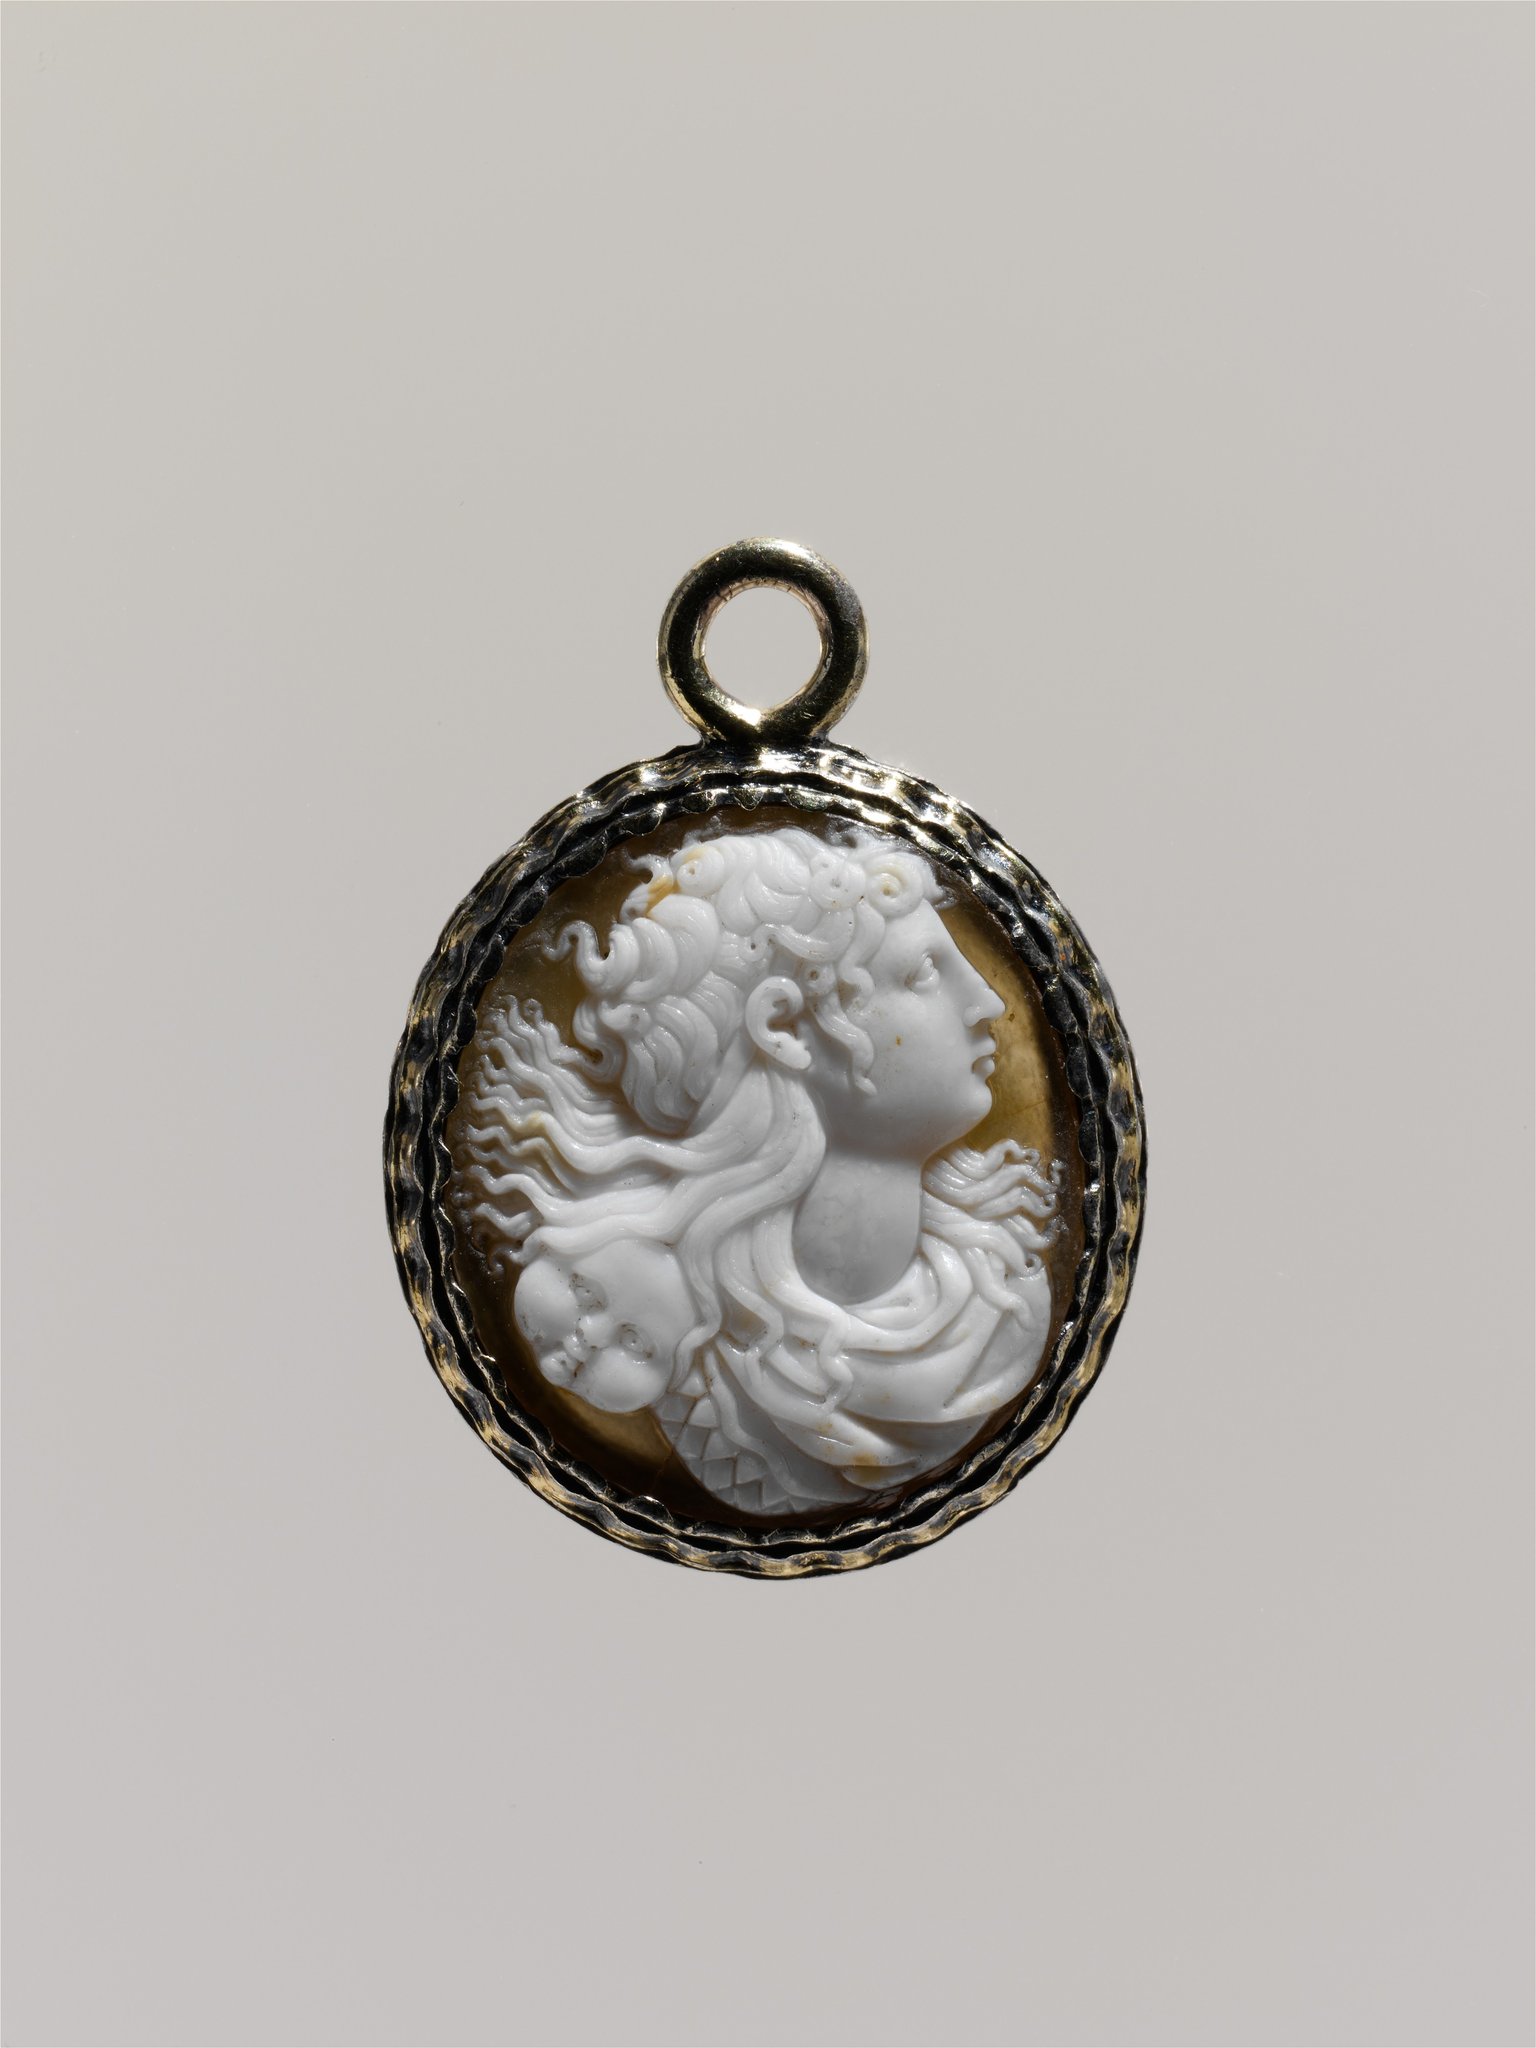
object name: cameo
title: Head of a Medusa (?)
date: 1534-1566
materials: onyx, gemstone, silver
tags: medusa